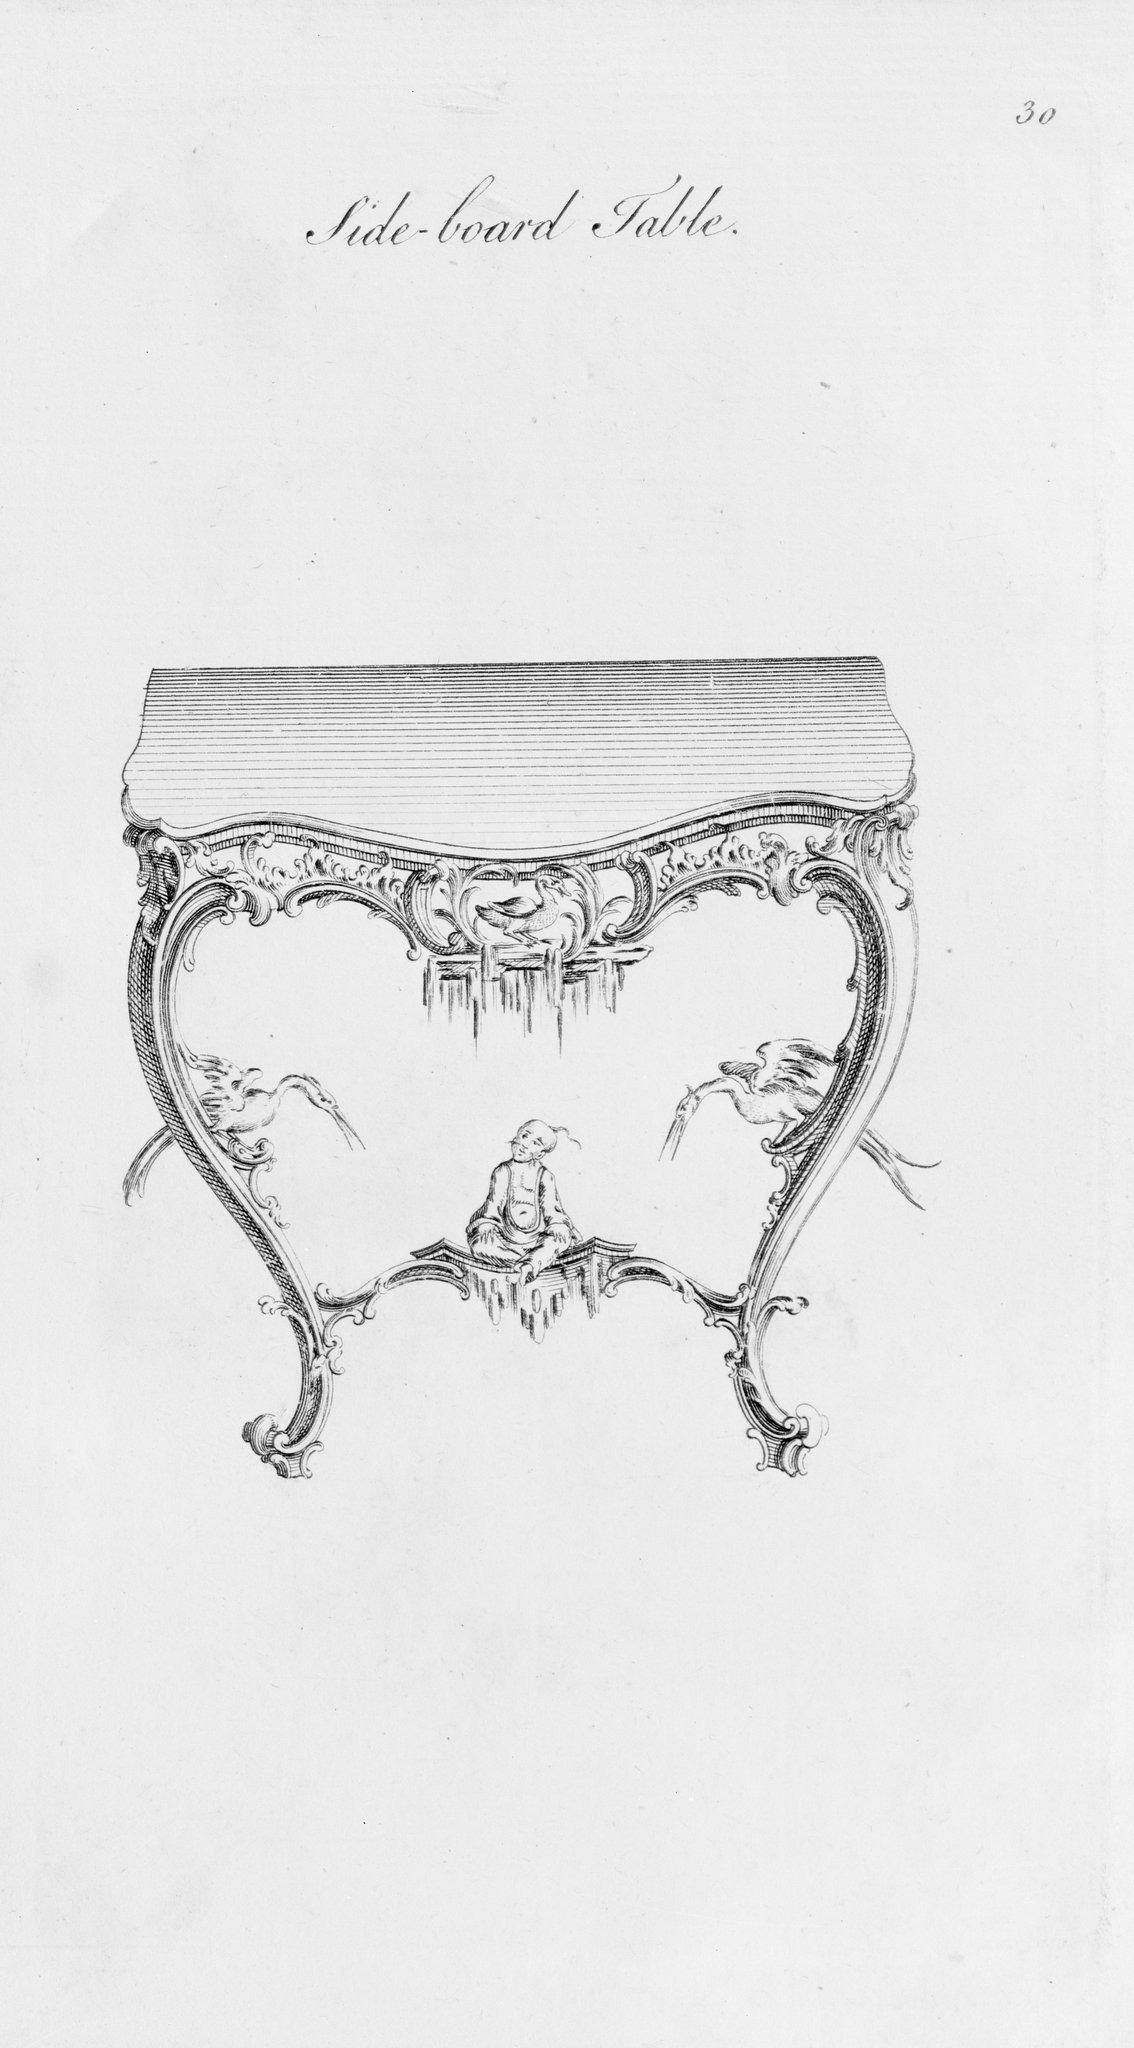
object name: book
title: The Second Edition of Genteel Household Furniture in the Present Taste, Part I, II, III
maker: the society of upholsterers, cabinet-makers, etc.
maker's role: author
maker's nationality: british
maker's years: 1700-1800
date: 1760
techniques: engraving, etching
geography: england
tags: furniture